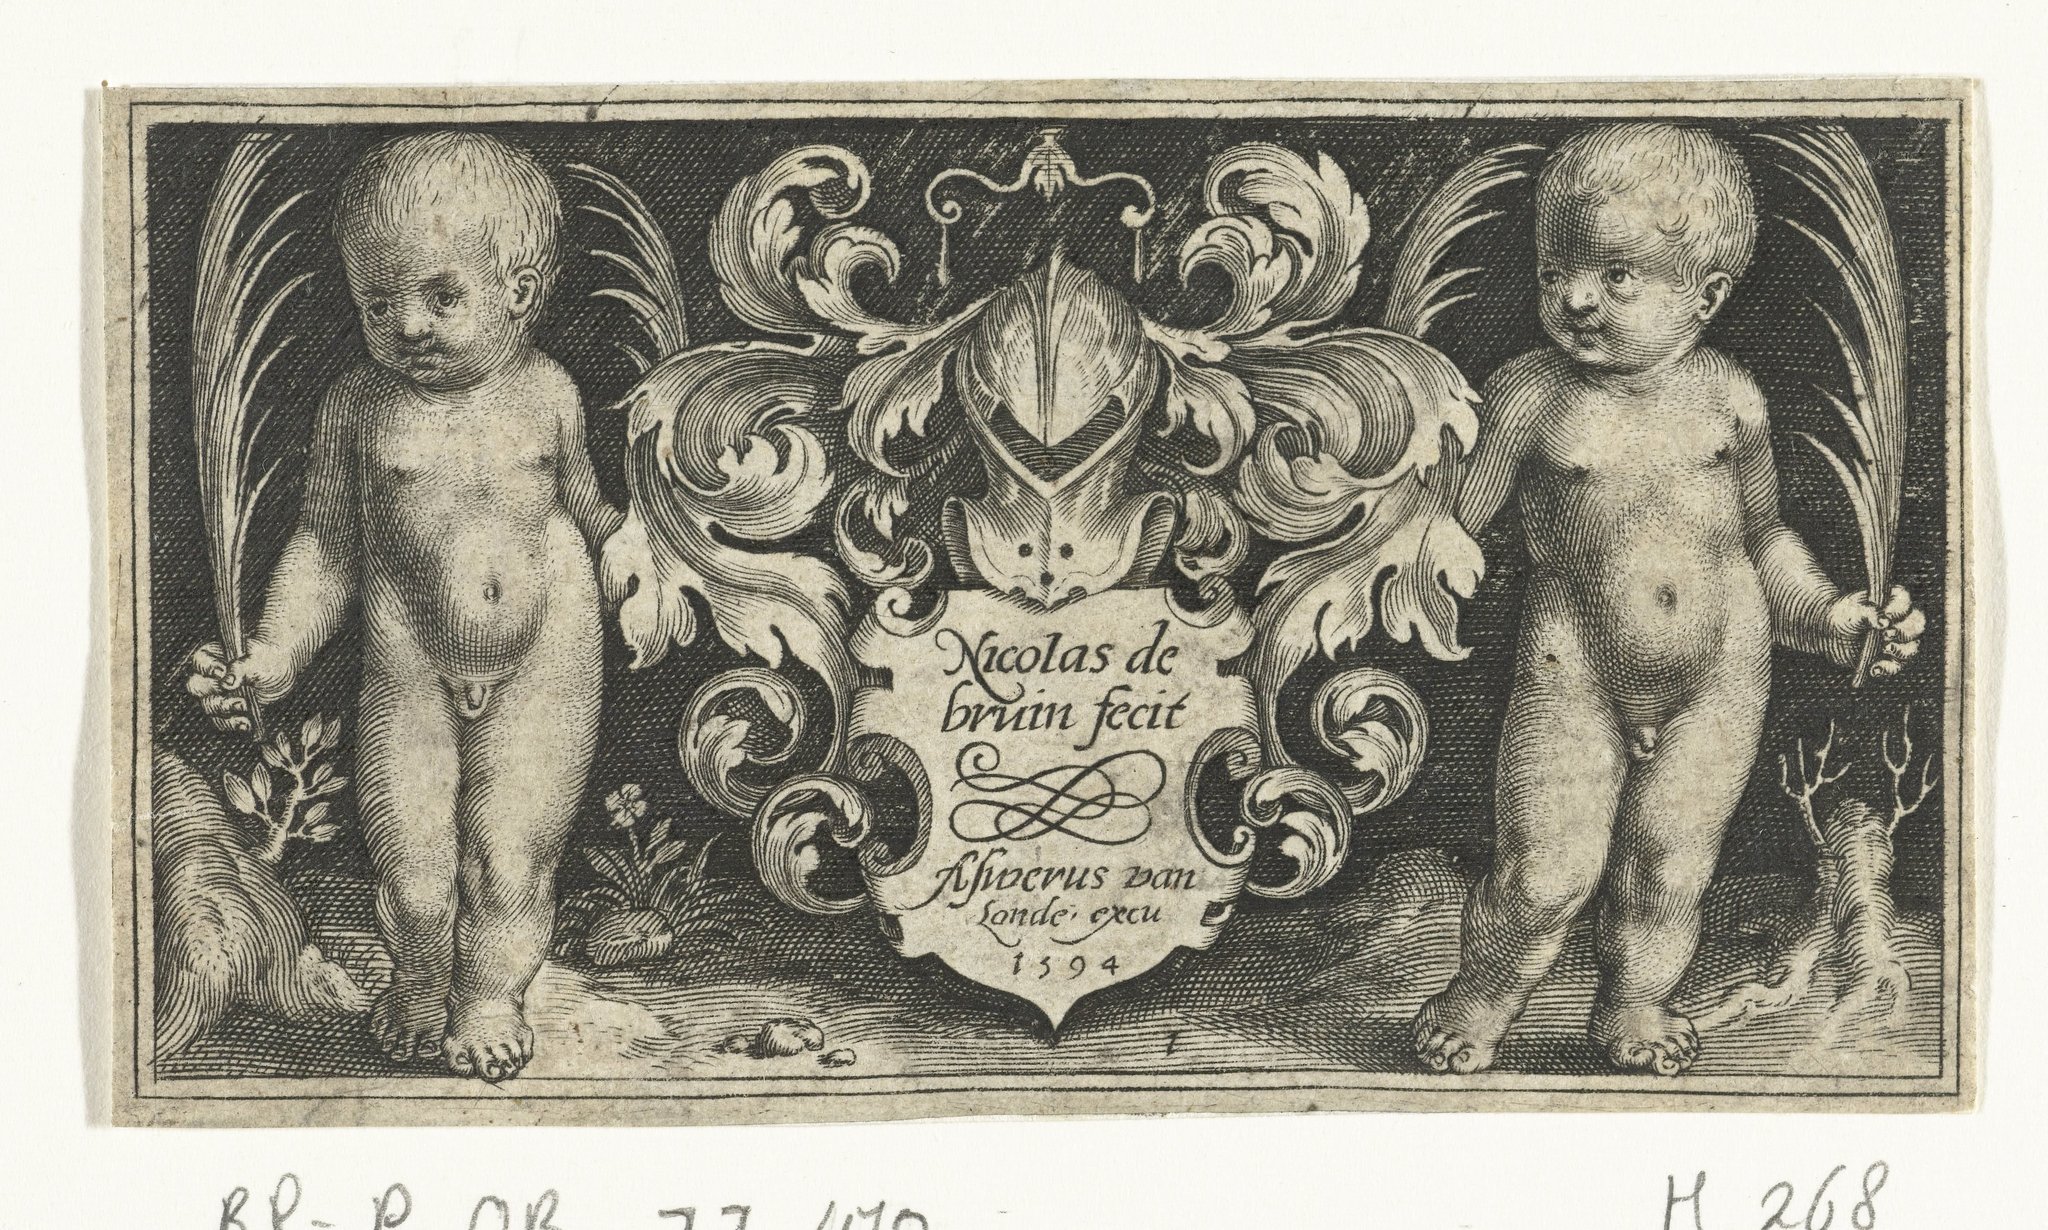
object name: print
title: Friezen met kinderen, engeltjes en dieren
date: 1594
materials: paper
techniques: engraving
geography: netherlands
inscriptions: collector's mark: Lugt 2228, collector's mark: Lugt 740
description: Prent uit serie van zes prenten met Friezen met kinderen, engeltjes en dieren. Hollstein beschrijft deze serie twee keer onder de nrs. 142-147 en 268-273.